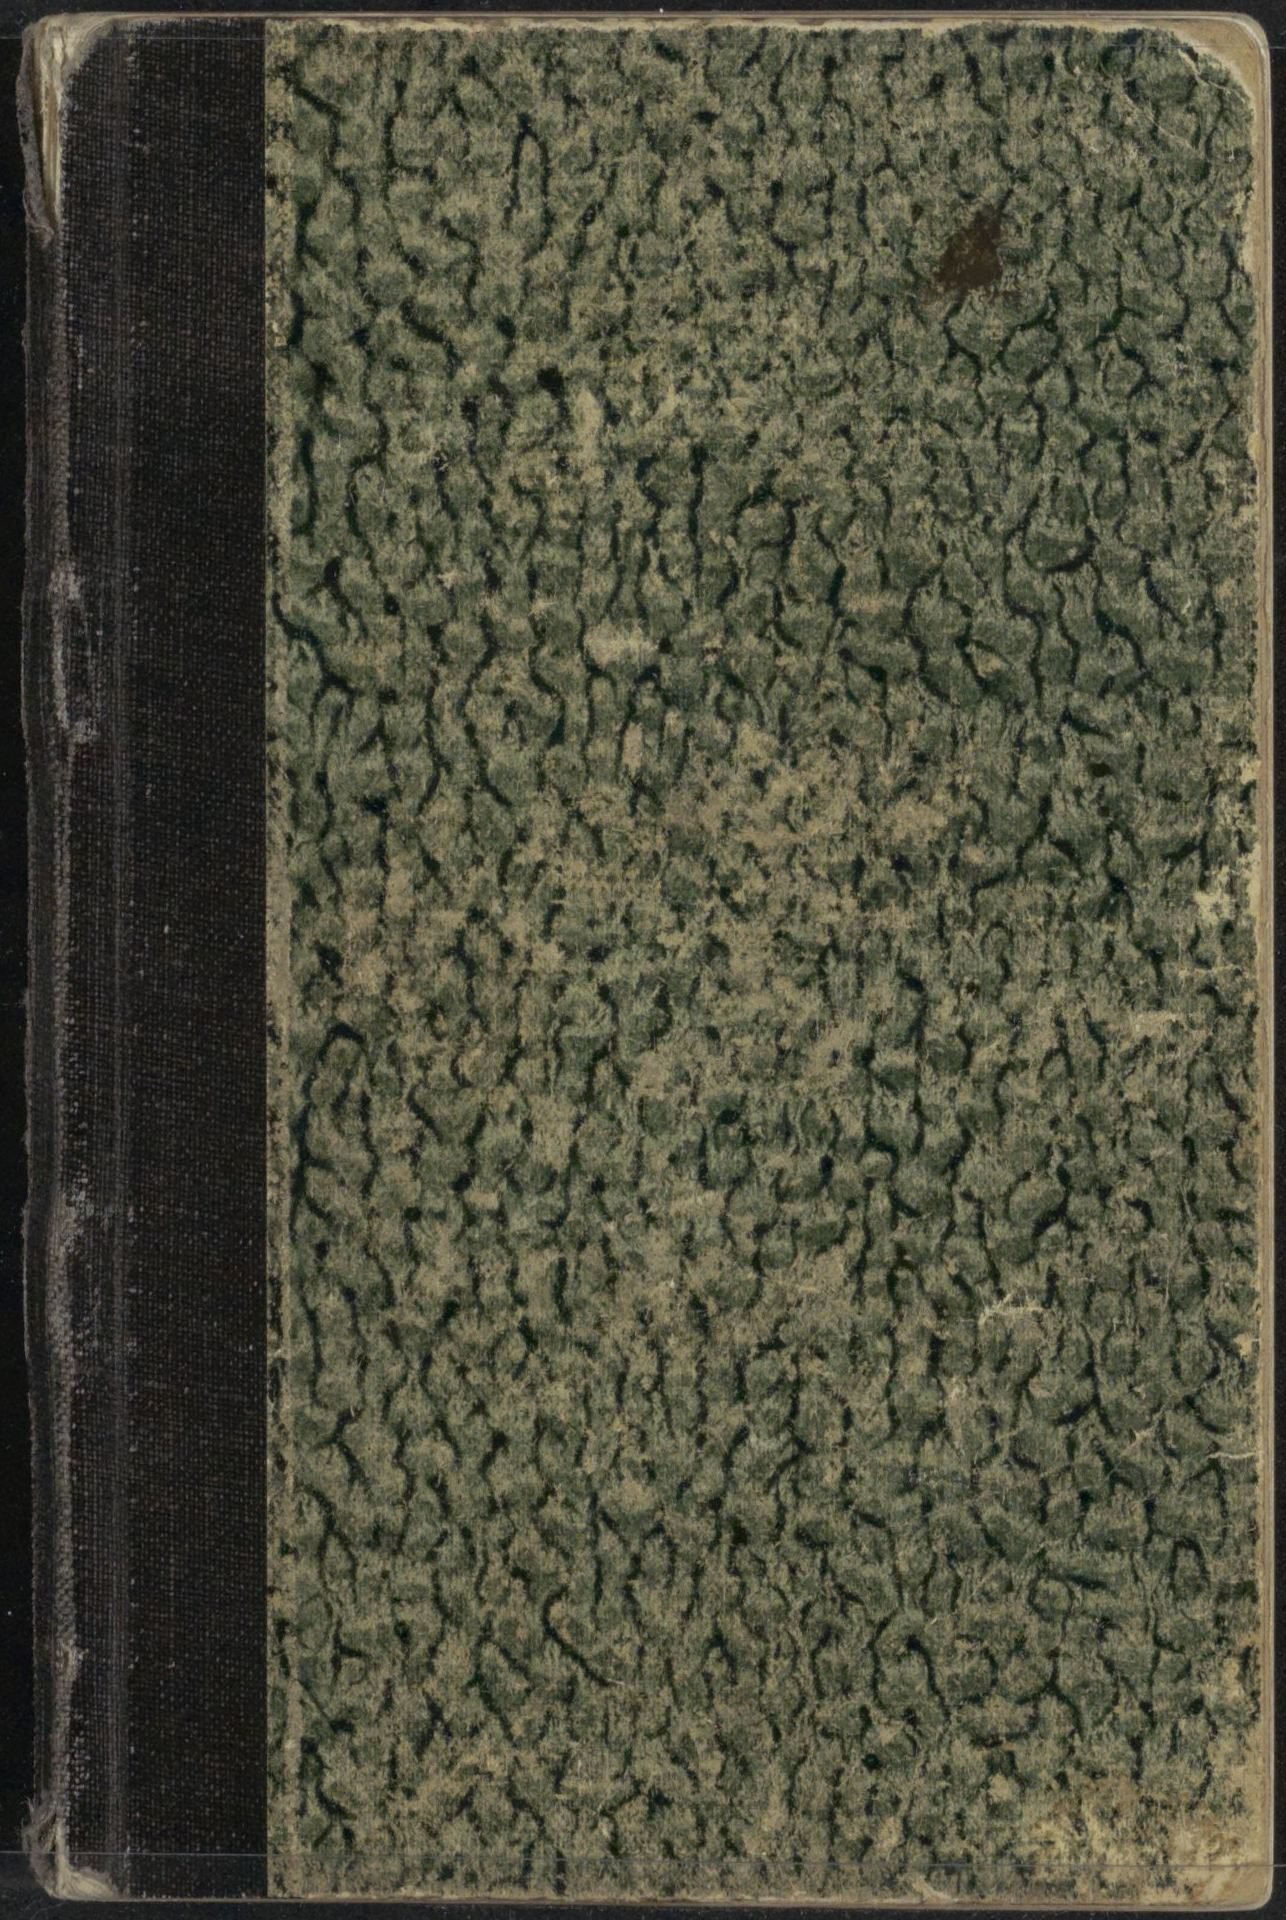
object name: sketchbook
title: Schetsboek met 46 bladen vervaardigd te Amsterdam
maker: george hendrik breitner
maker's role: draughtsman, painter, print maker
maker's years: 1857-1923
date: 1909-1912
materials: cardboard, chalk, linen, paper, pencil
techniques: marbling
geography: amsterdam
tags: urban housing, horse, street, (farm) wagon, freight wagon, cart, amsterdam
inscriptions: date: ‘Sept/ 1912’, retailer's mark: ‘Gebrs. Simons/ Amsterdam./ Filiaal/ Heiligenweg 34/ Kantoorboek & Papierhandel./ Linieer- en Perforeer-inrichting./ No. 141 Blanco/ Bij nabestelling van dit boek, gelieve men/ bovenstaand nummer op te geven. / per doz f 1.60 per stuk 15’, collector's mark: Lugt 2228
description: Schetsboek bestaande uit 46 bladen met gezichten te Amsterdam, figuurstudies en paard en wagens.